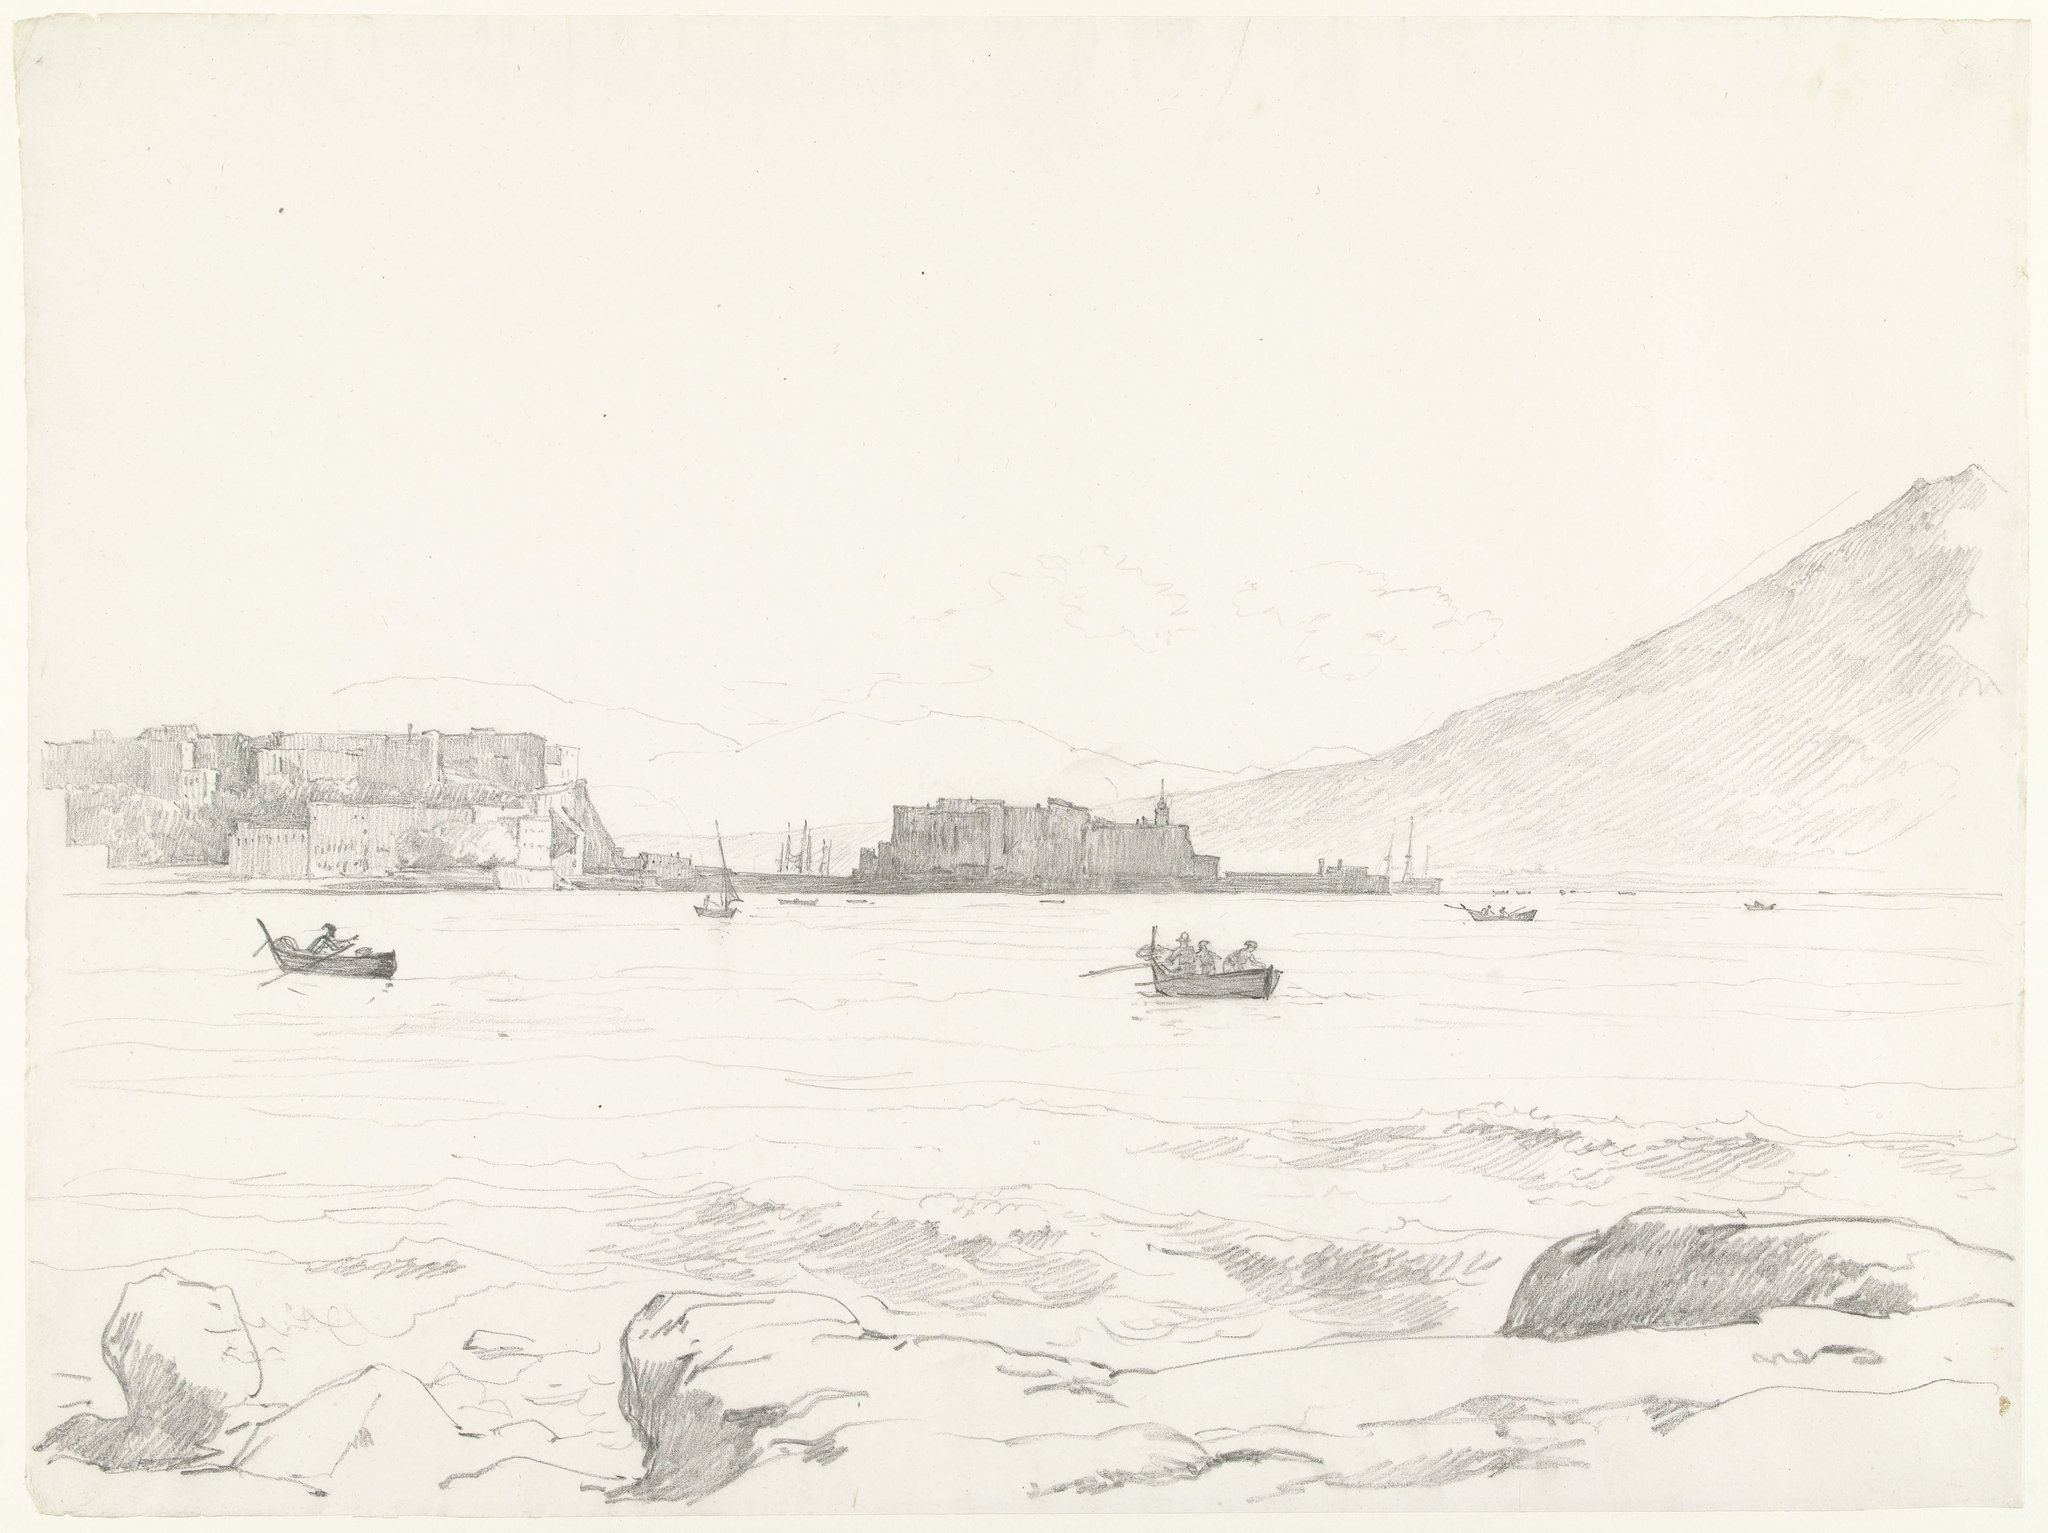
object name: drawing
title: Castel del'Uovo aan de golf van Napels met roeiboten op het water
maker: hendrik voogd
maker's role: draughtsman, painter, print maker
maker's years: 1768-1839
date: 1788-1839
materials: chalk, paper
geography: rome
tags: castle, coast, naples